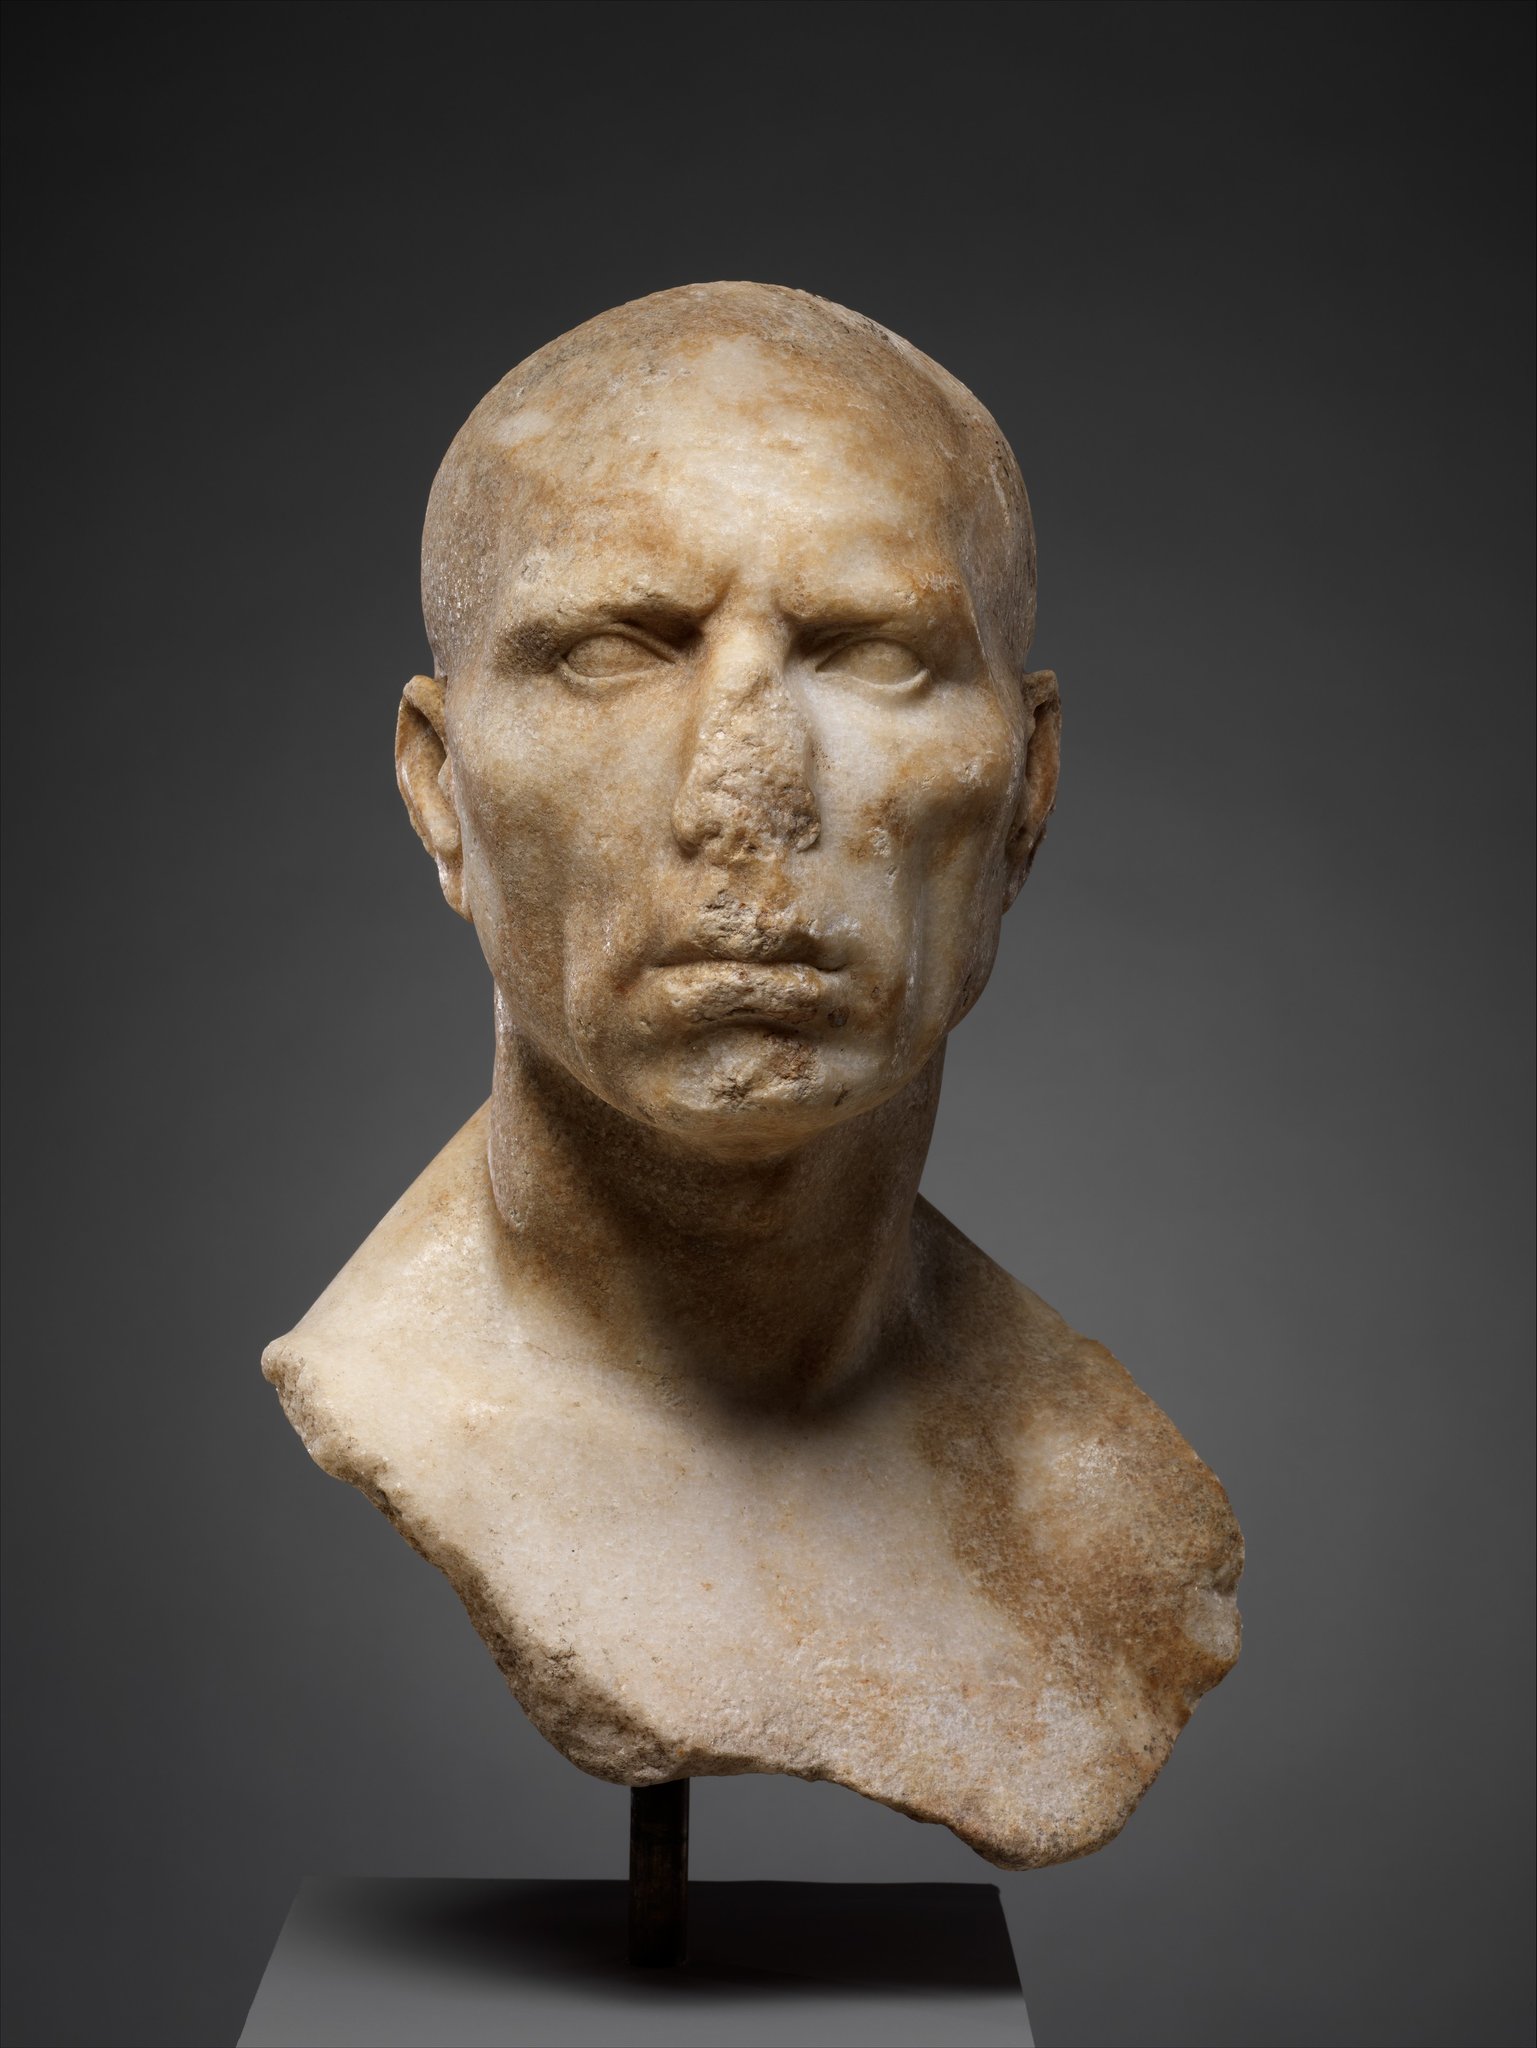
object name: portrait bust of a man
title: Marble portrait bust of a man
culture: roman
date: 34-66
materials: marble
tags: men,portraits